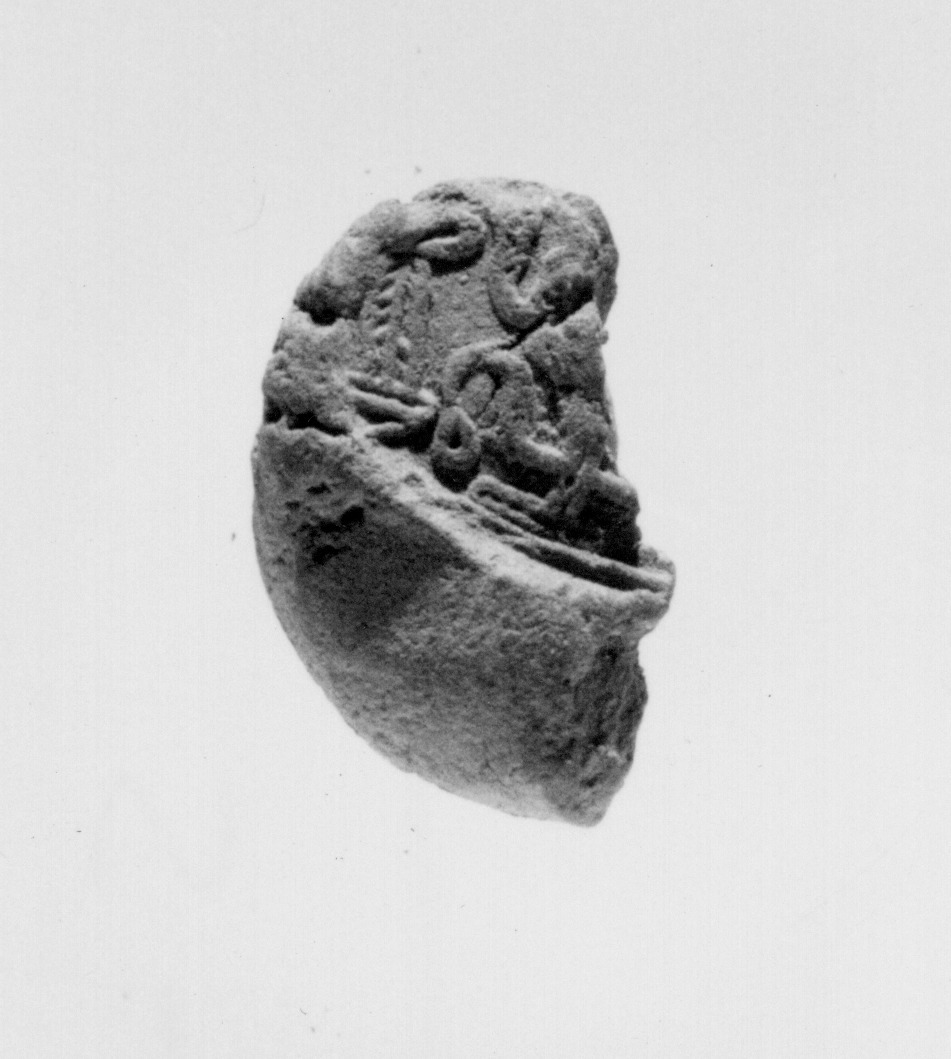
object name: sealing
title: Document Sealing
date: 1390-1352 BCE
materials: mud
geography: egypt